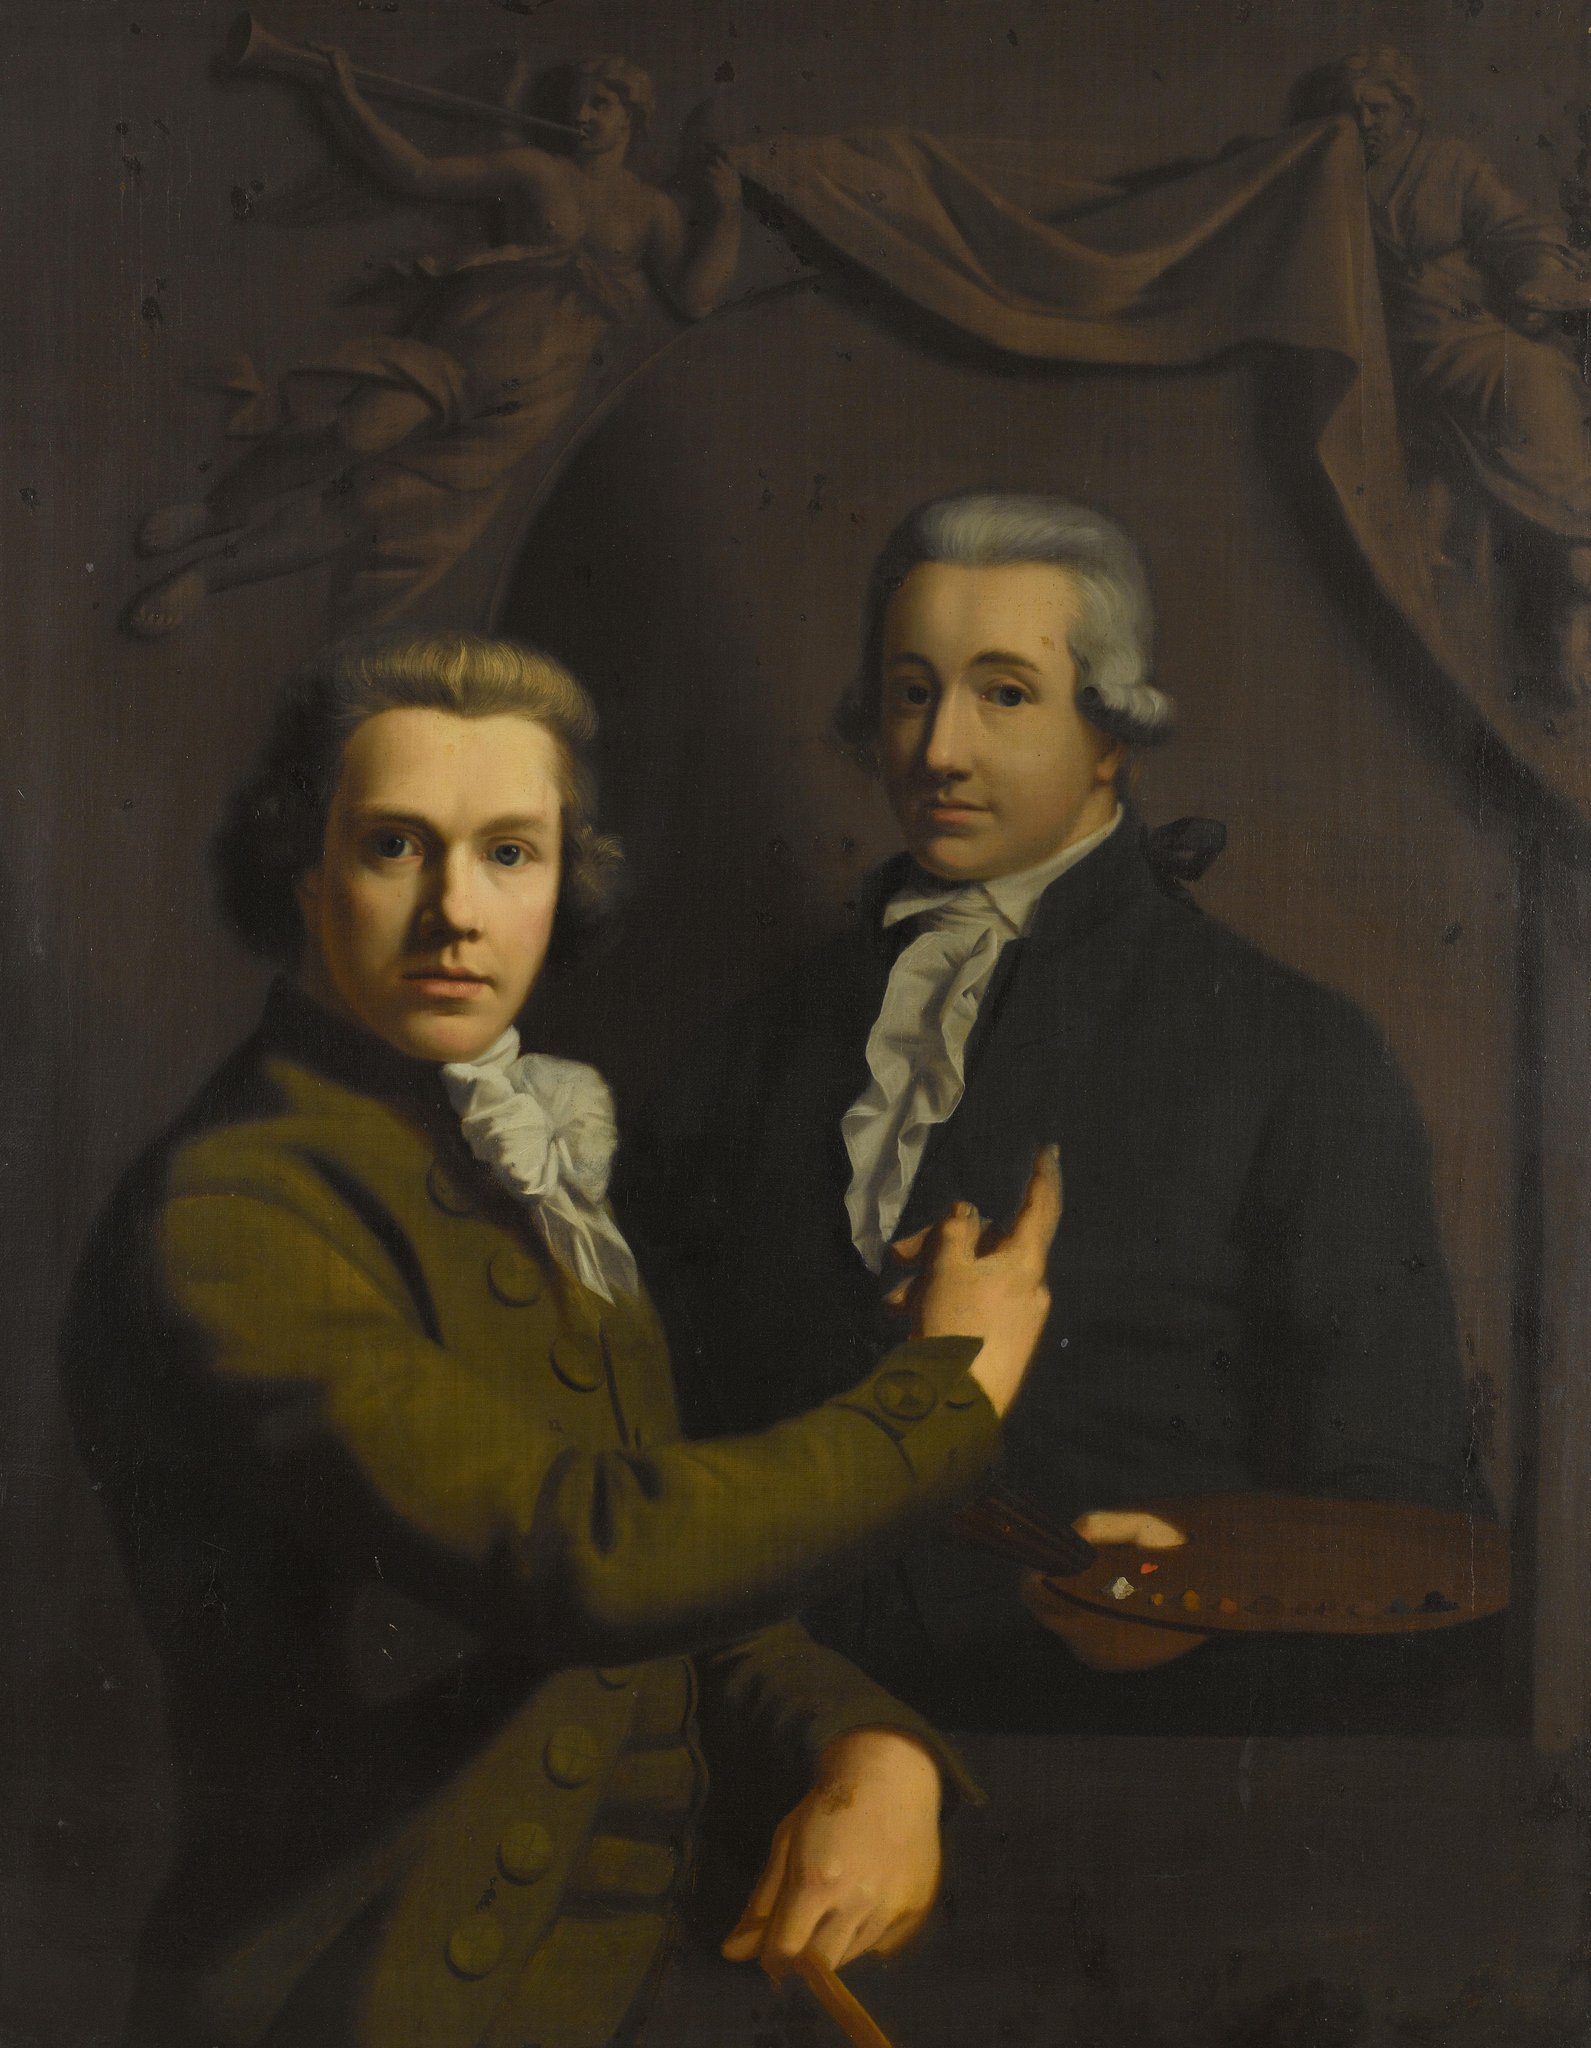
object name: painting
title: Self Portrait, Pointing at a Portrait of the Artist's deceased Colleague Dirk Jacobsz Ploegsma (1769-91)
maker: willem bartel van der kooi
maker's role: draughtsman, painter, print maker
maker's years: 1768-1836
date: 1791-1795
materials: canvas, oil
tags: draughtsman, print maker, willem bartel van der kooi, historical persons, portrait, self-portrait of painter, portrait, self-portrait of artist, picture, painting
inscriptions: inscription: ‘Ter nagedachtenis van Dirk Jacobs Ploegsma / geboren te Leeuwarden den 19 Februarij 1769 en overleden 21 mei 1791 / geschilderd door W.B. van der Kooi’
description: Zelfportret van Willem Bartel van der Kooi, staand ten halven lijve, wijzend naar het portret van zijn gestorven collega Dirk Jacobsz Ploegsma. Ploegsma is voorgesteld met palet en penselen in de hand, boven het portret een treurende allegorische figuur (Schilderkunst?) en de Faam.